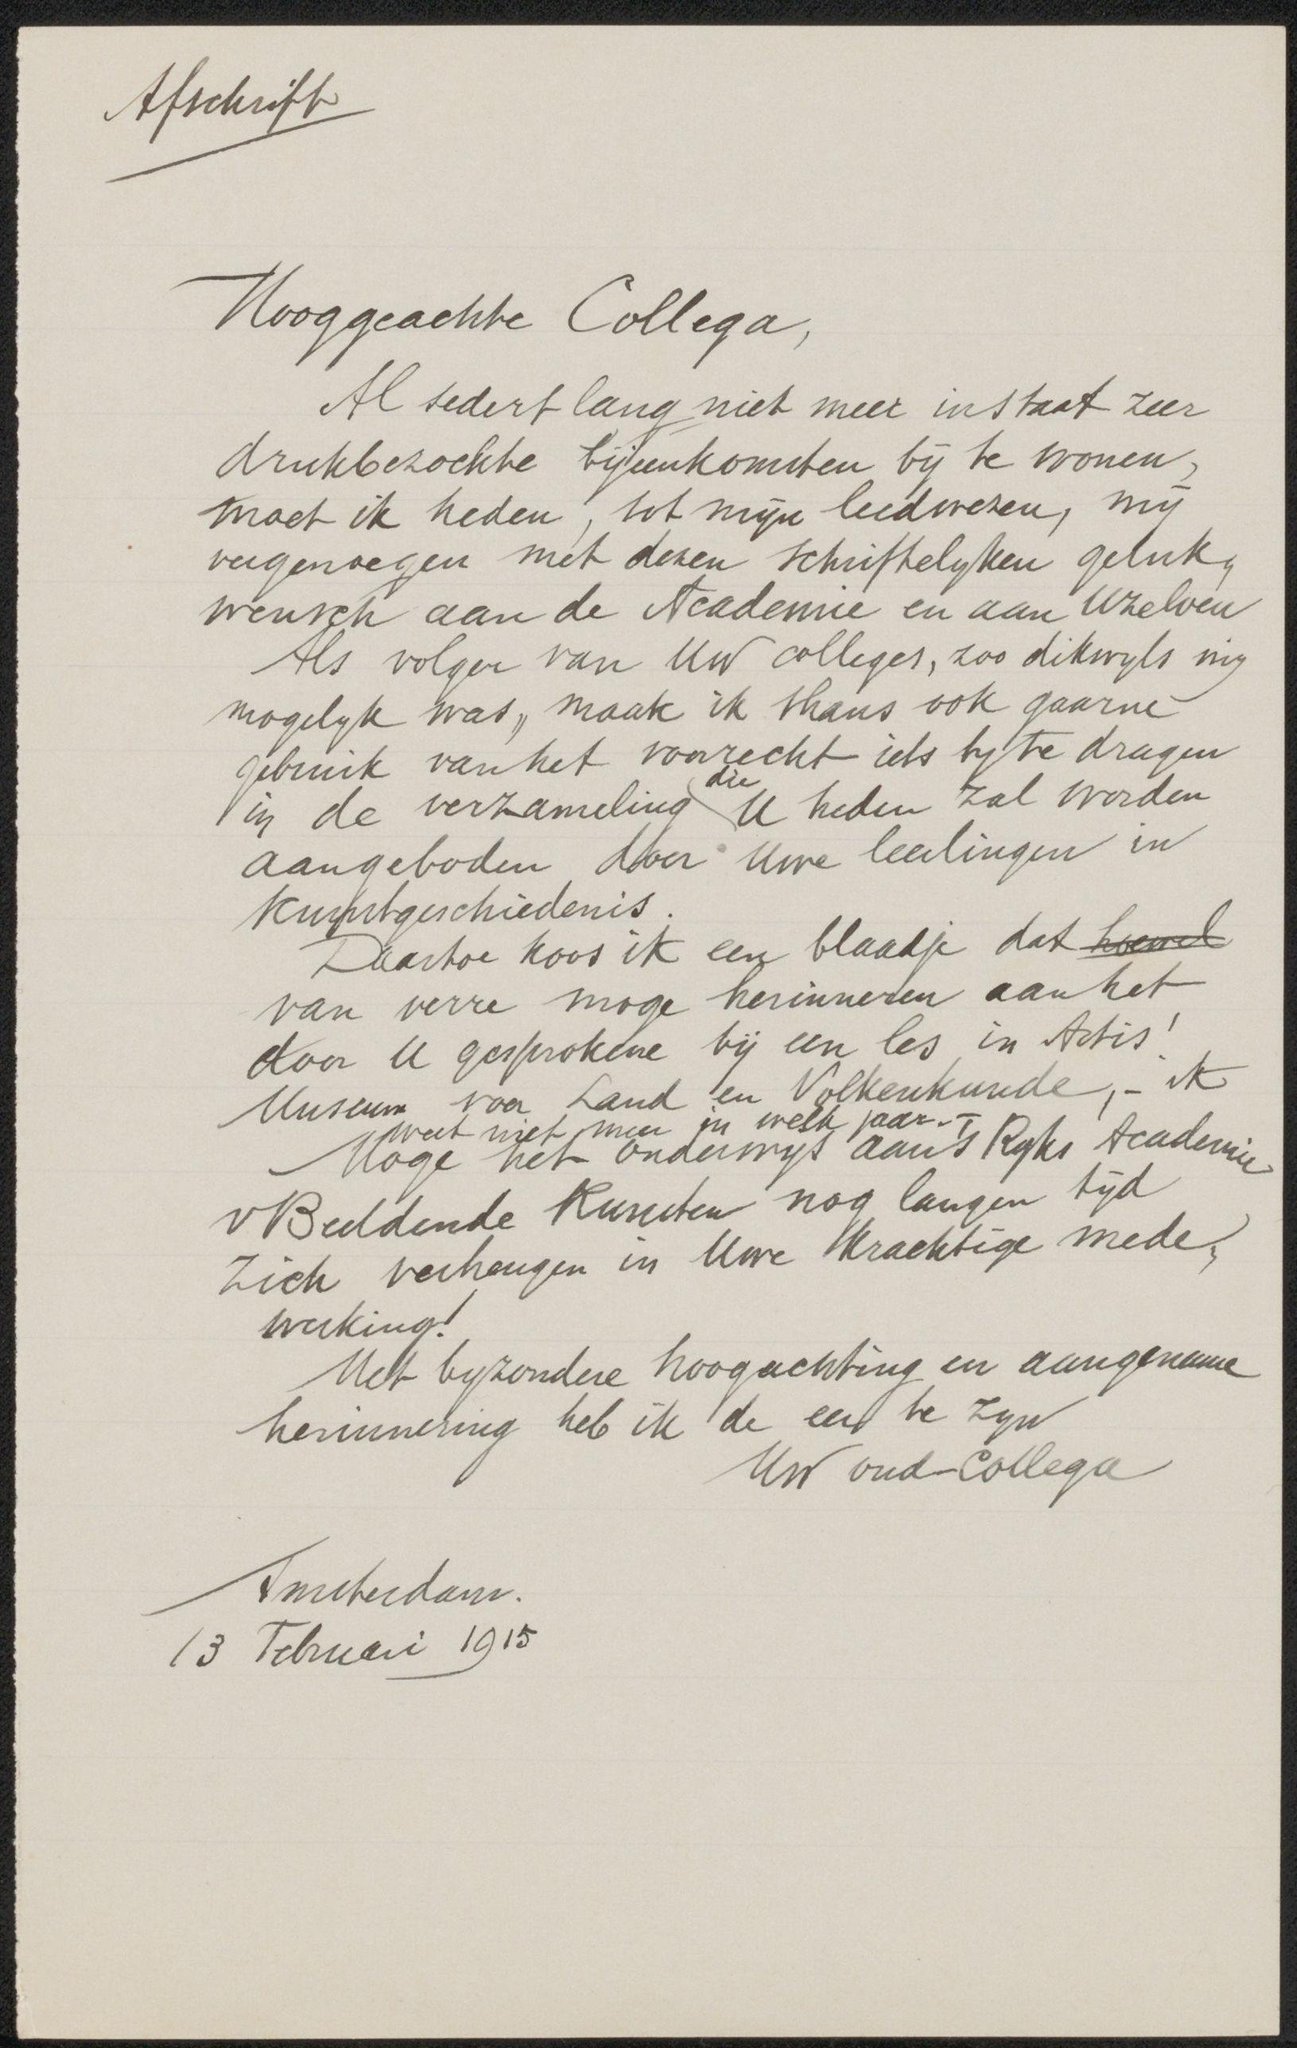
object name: letter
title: Brief aan anoniem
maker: august allebé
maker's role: draughtsman, print maker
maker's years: 1838-1927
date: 1915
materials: ink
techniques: pen, writing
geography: amsterdam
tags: education, tuition of the artist (in general)